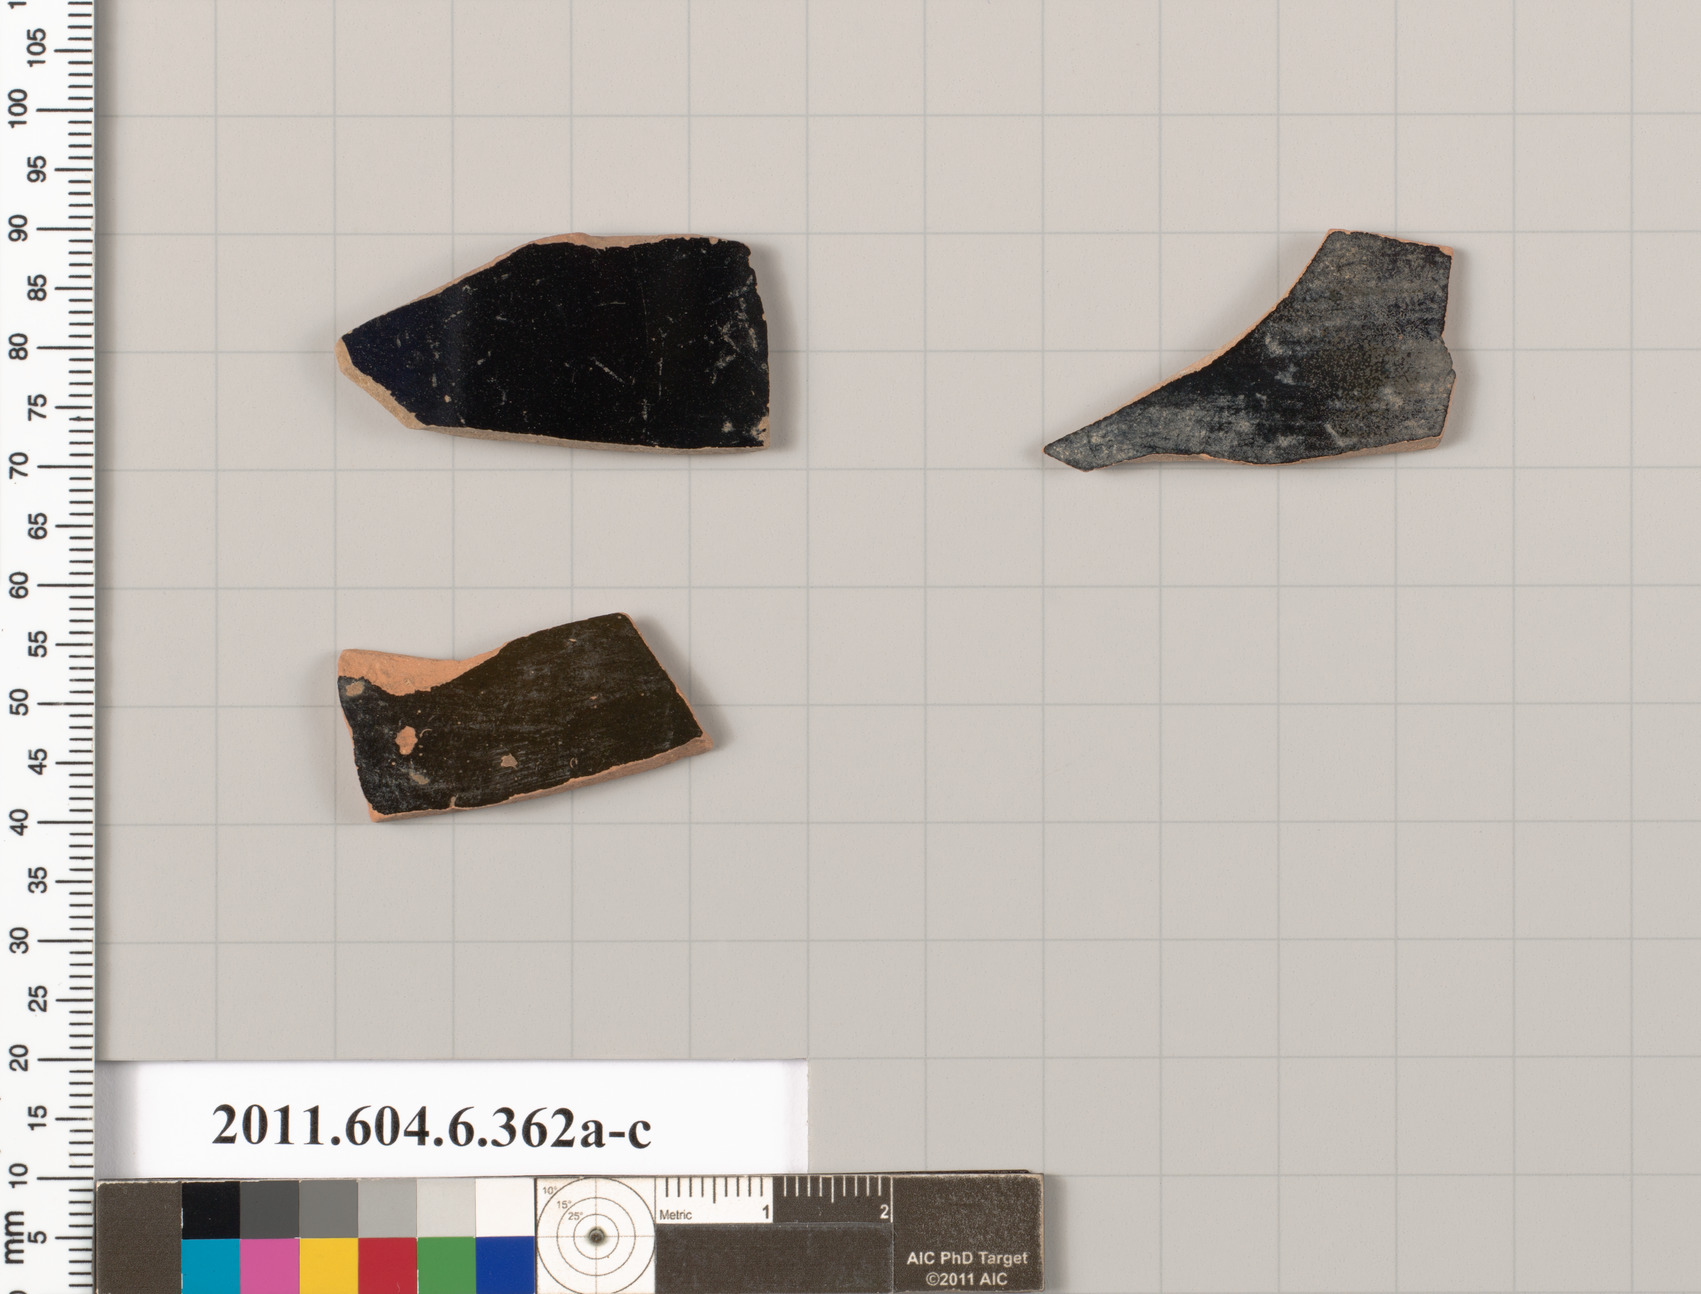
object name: undetermined closed shape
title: Terracotta fragments of closed shapes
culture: greek, attic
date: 600-401 BCE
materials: terracotta